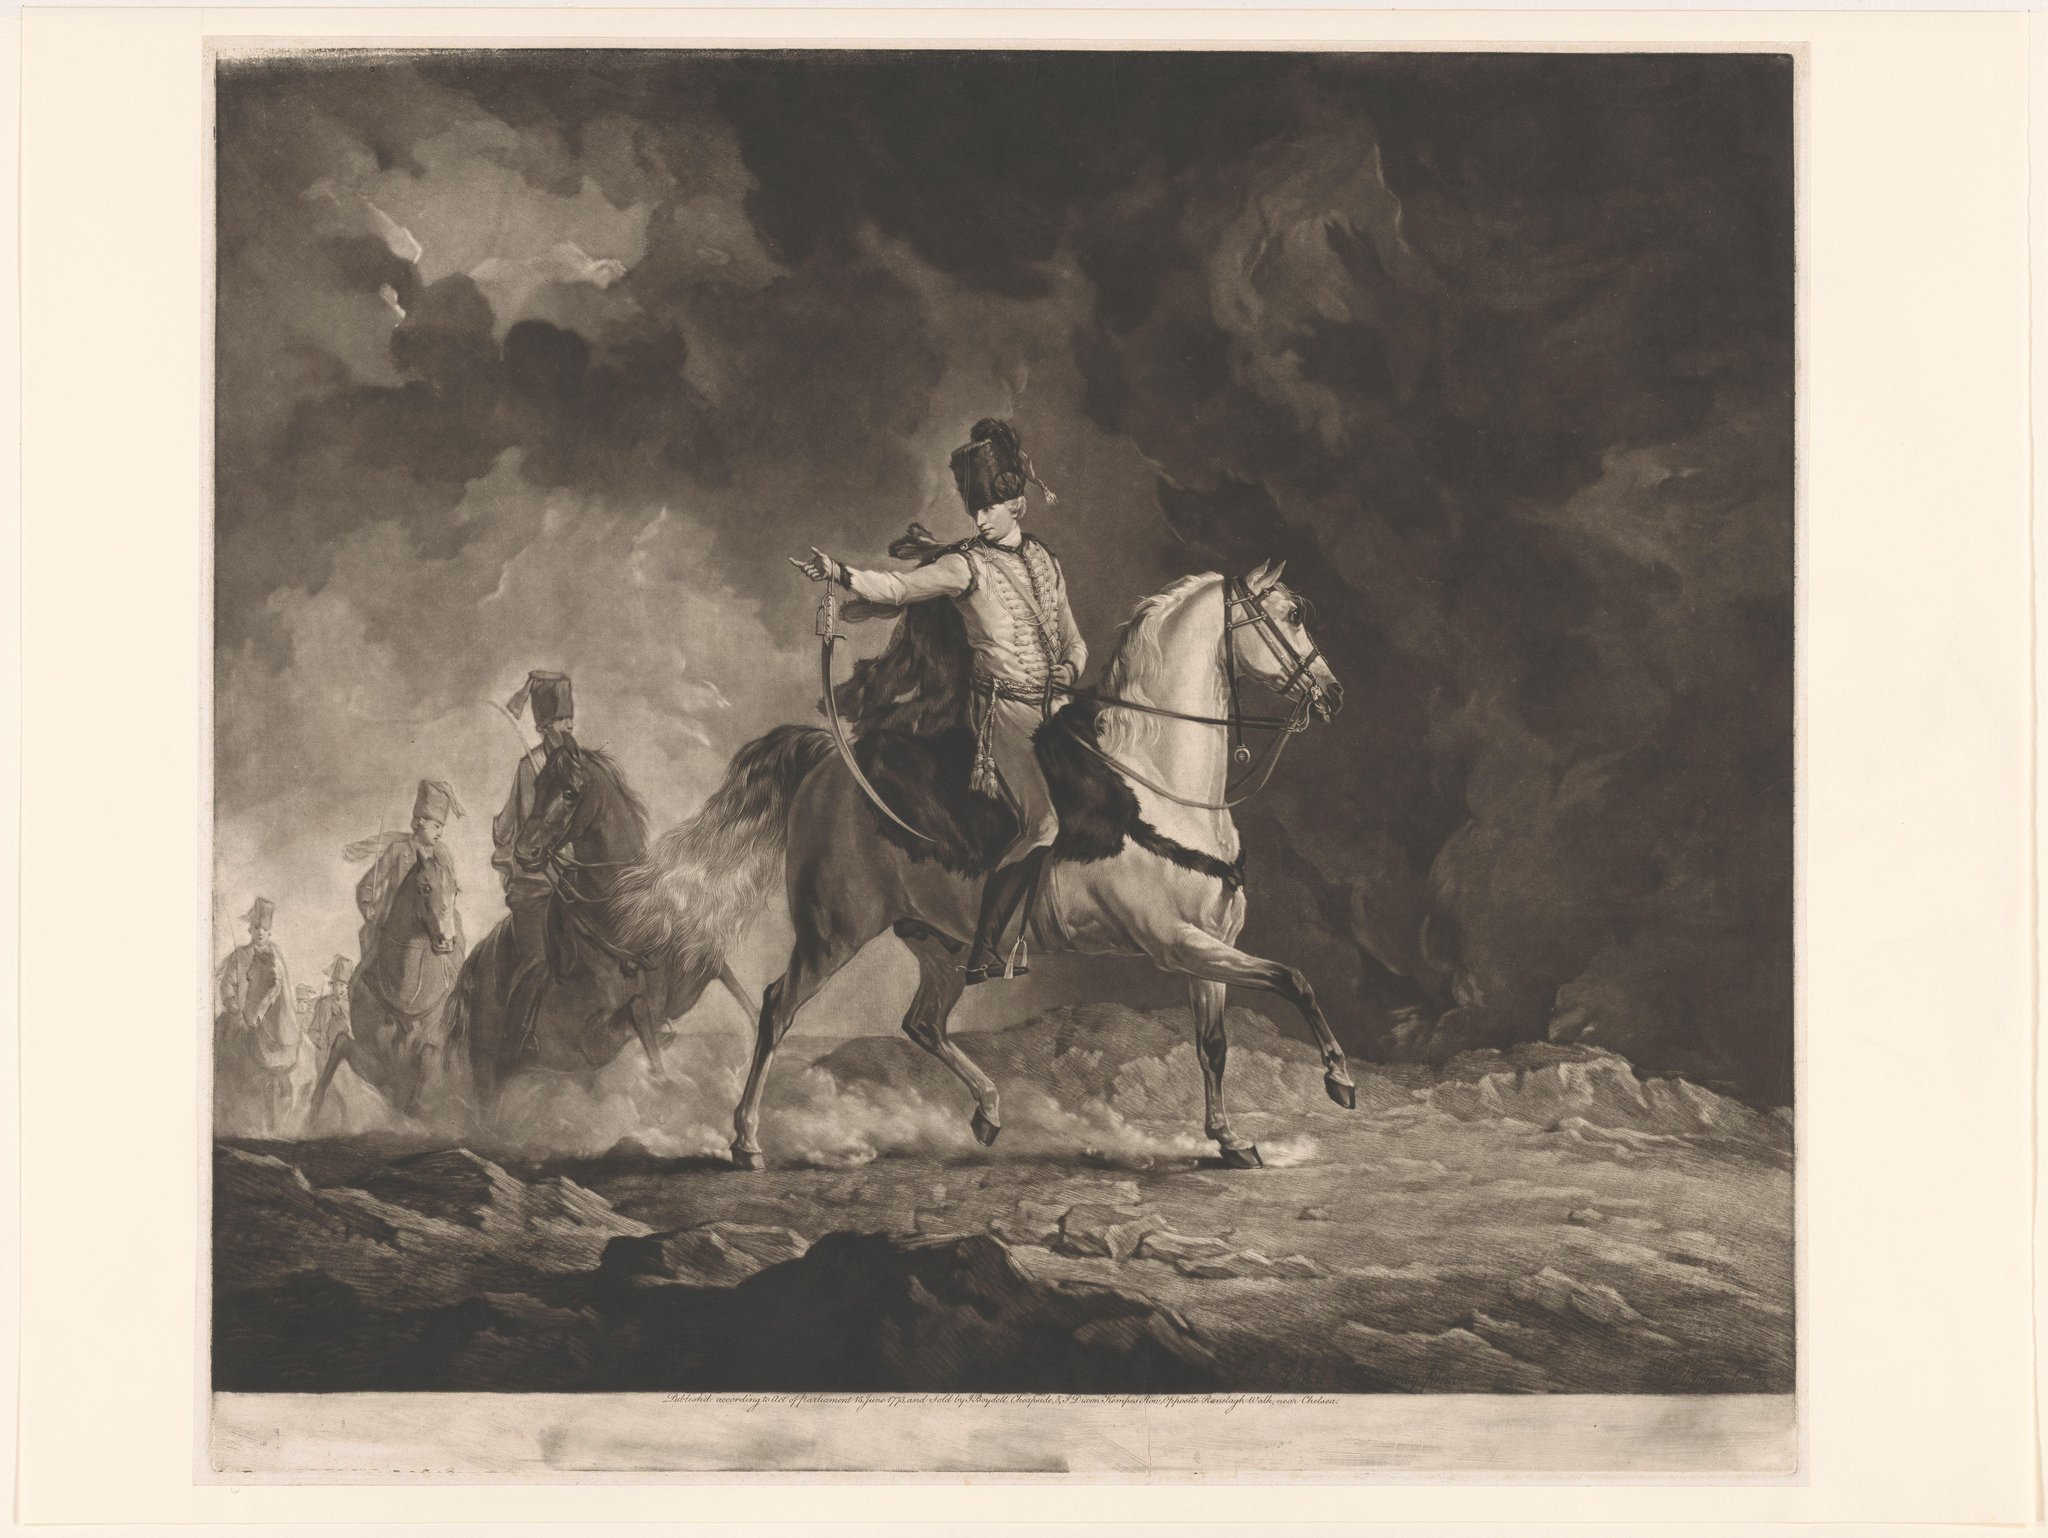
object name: print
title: Portret van William John Kerr, graaf van Ancrum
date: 1773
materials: paper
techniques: etching, roulette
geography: london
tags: commander-in-chief, general, marshal, historical persons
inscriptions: collector's mark: Lugt 240